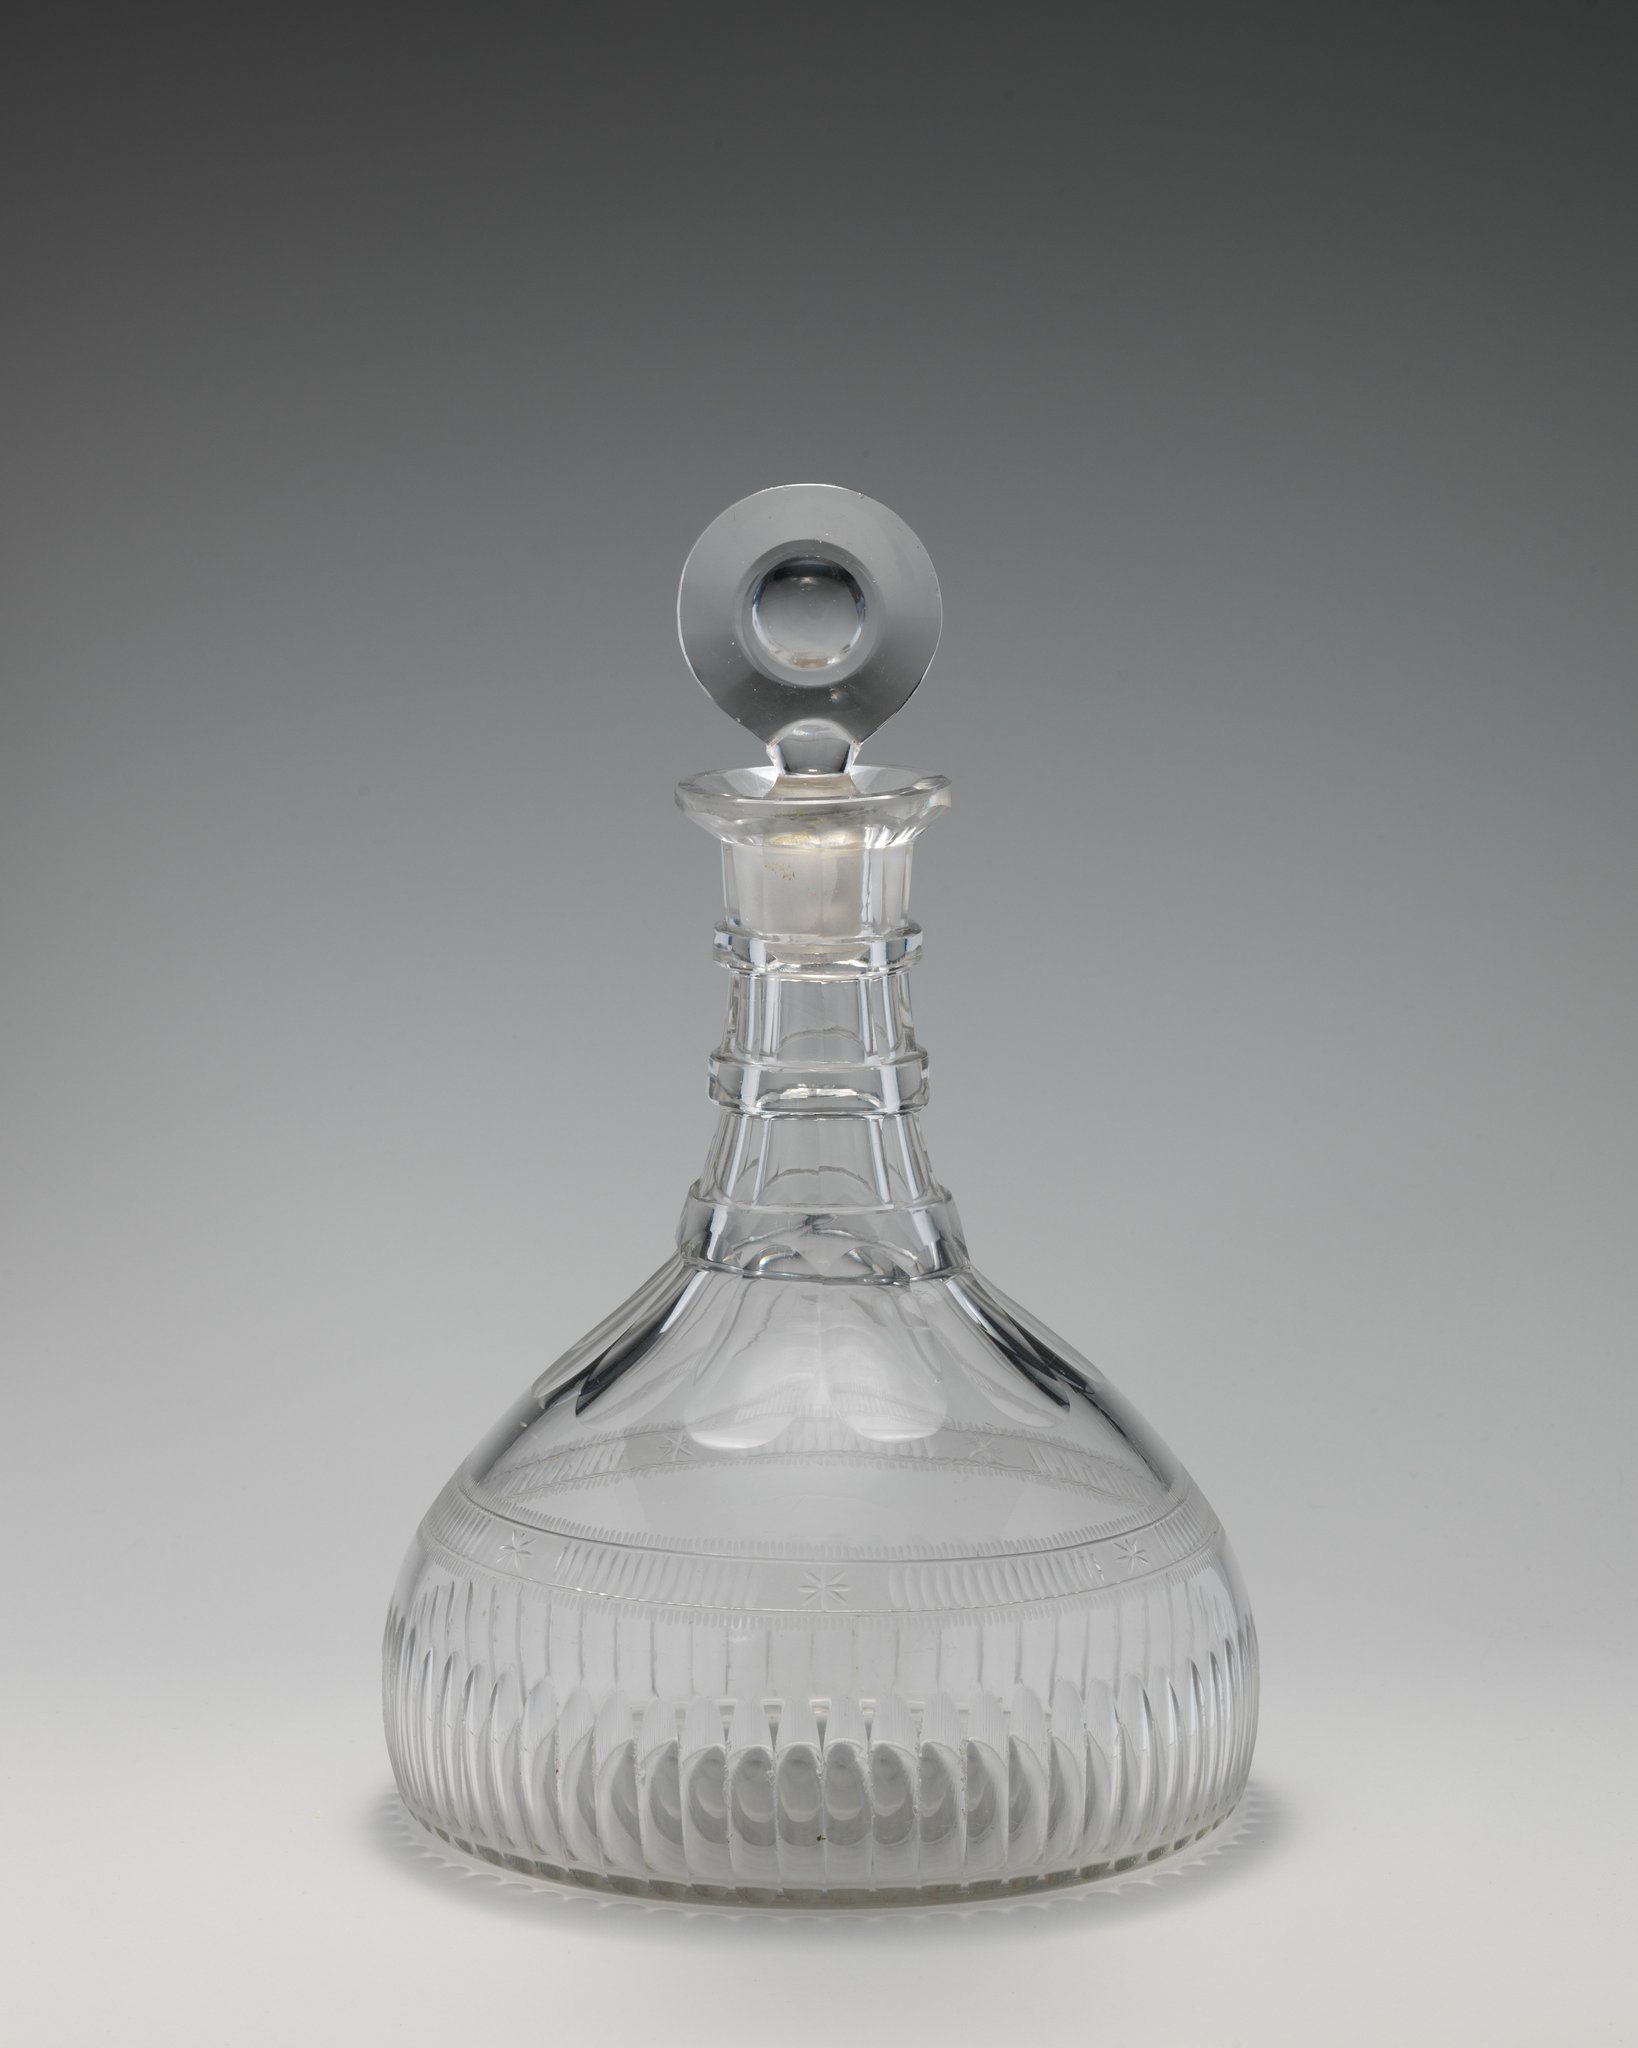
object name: decanter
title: Ship decanter (one of a pair)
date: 1830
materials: glass, lead